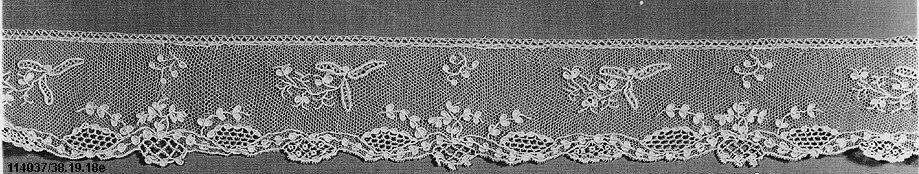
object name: sleeve trimming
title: Sleeve ruffle (Engageante) (one of a pair)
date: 1774-1793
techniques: lace